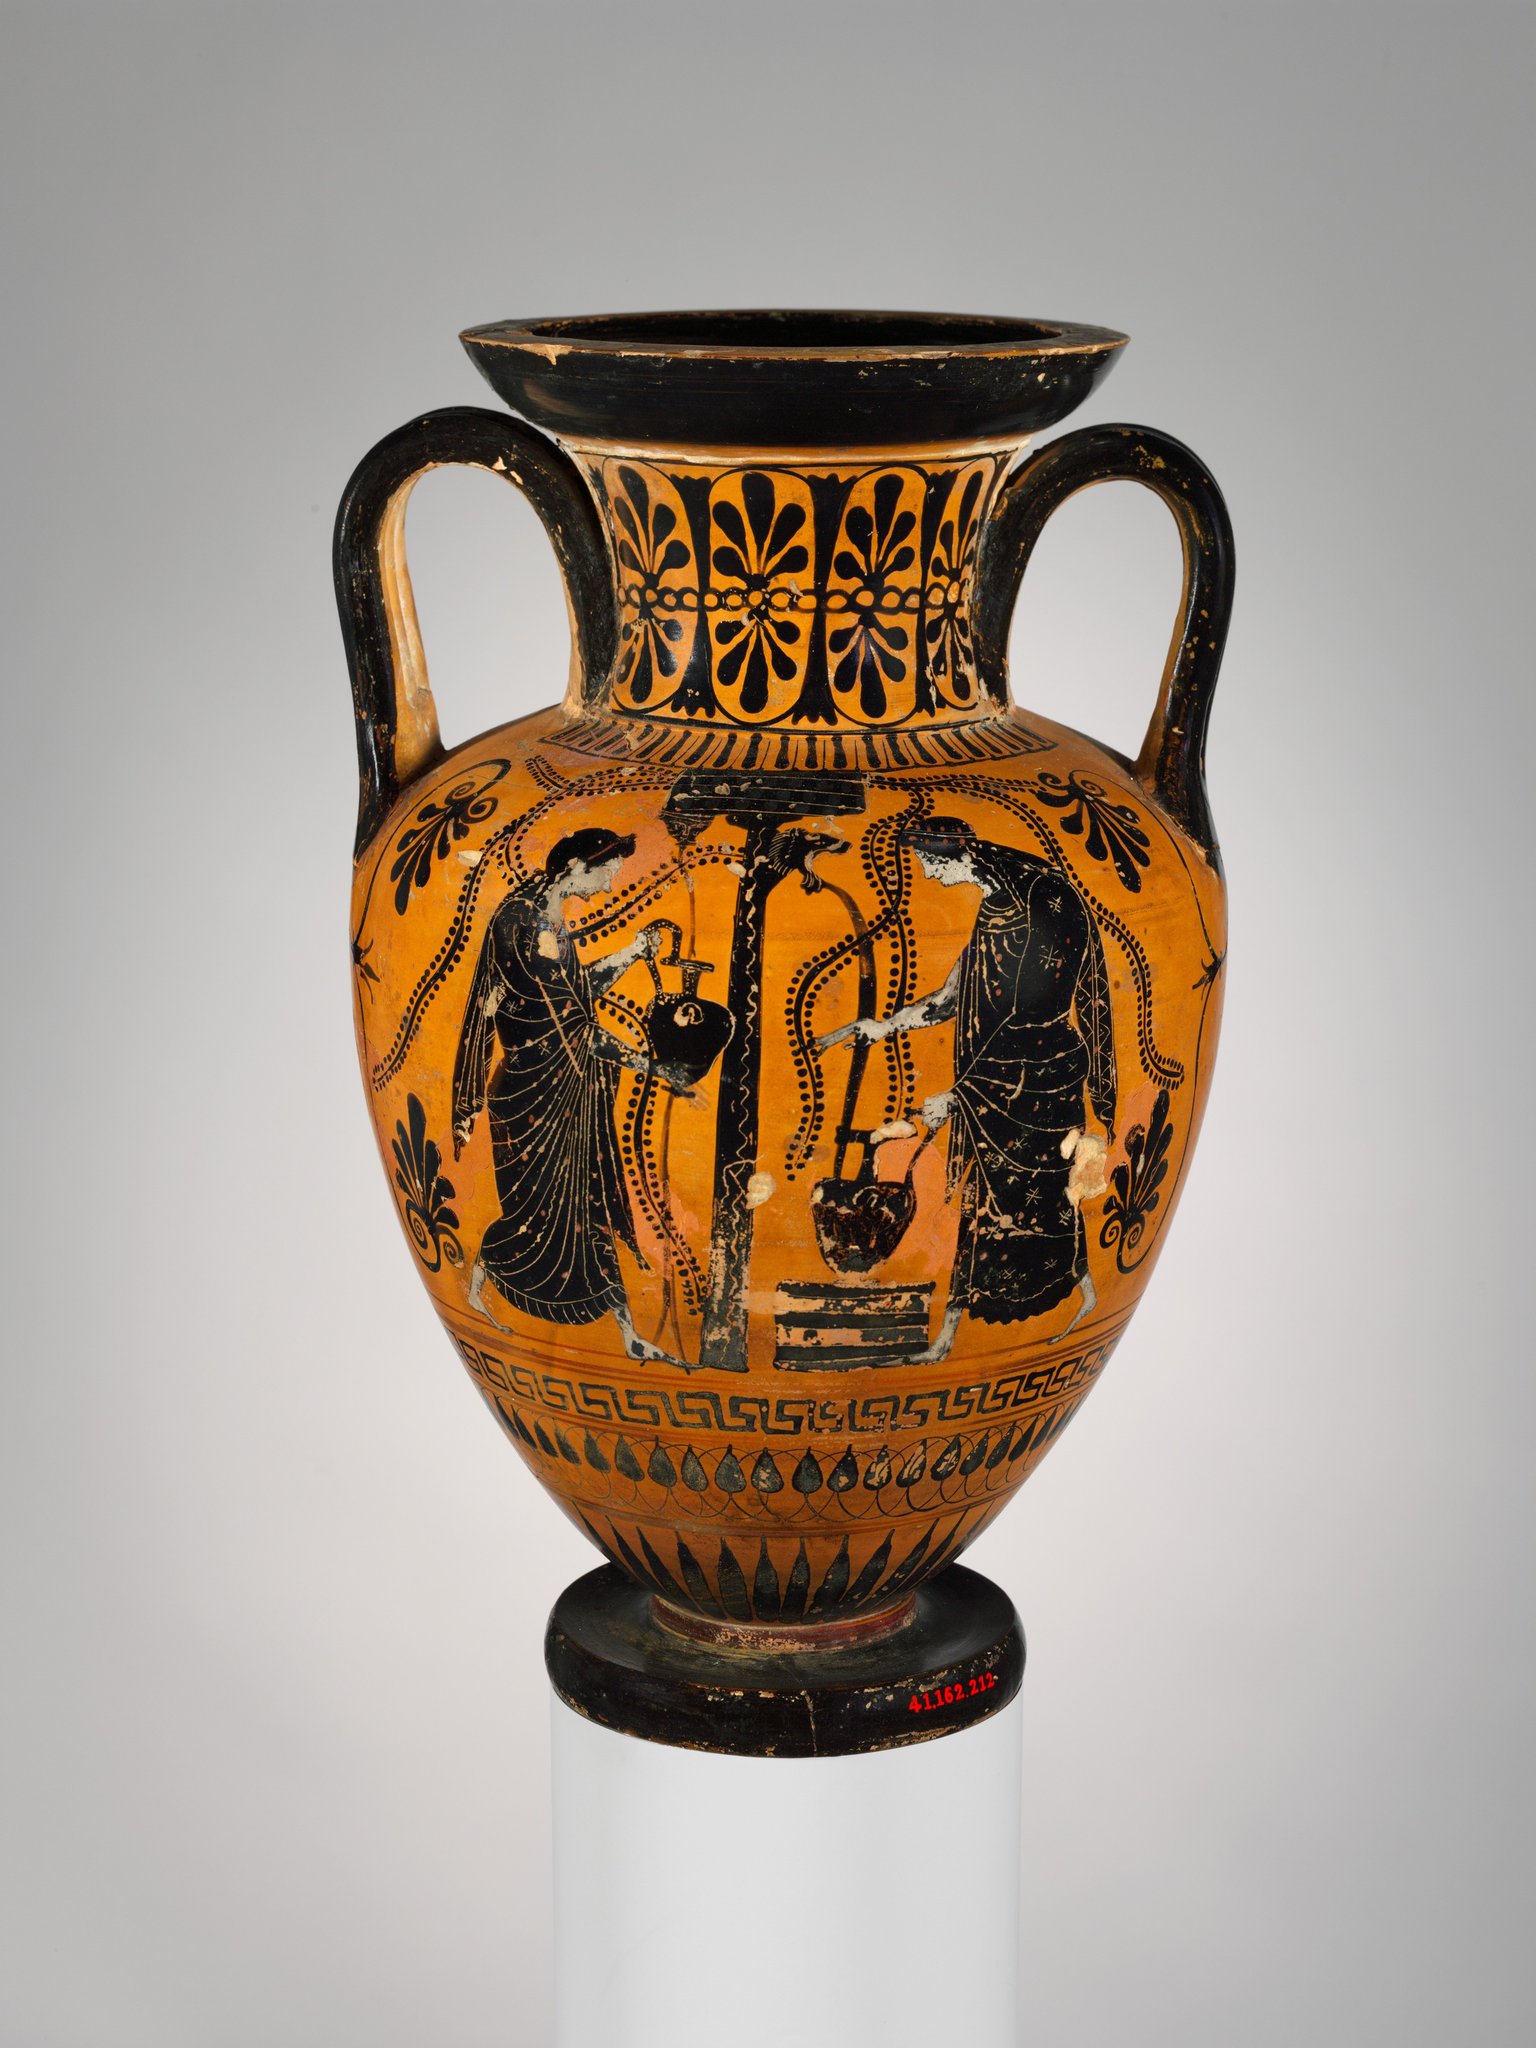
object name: neck amphora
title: Terracotta neck-amphora (jar)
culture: greek, attic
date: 500 BCE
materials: terracotta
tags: fountains,women,lions,herakles